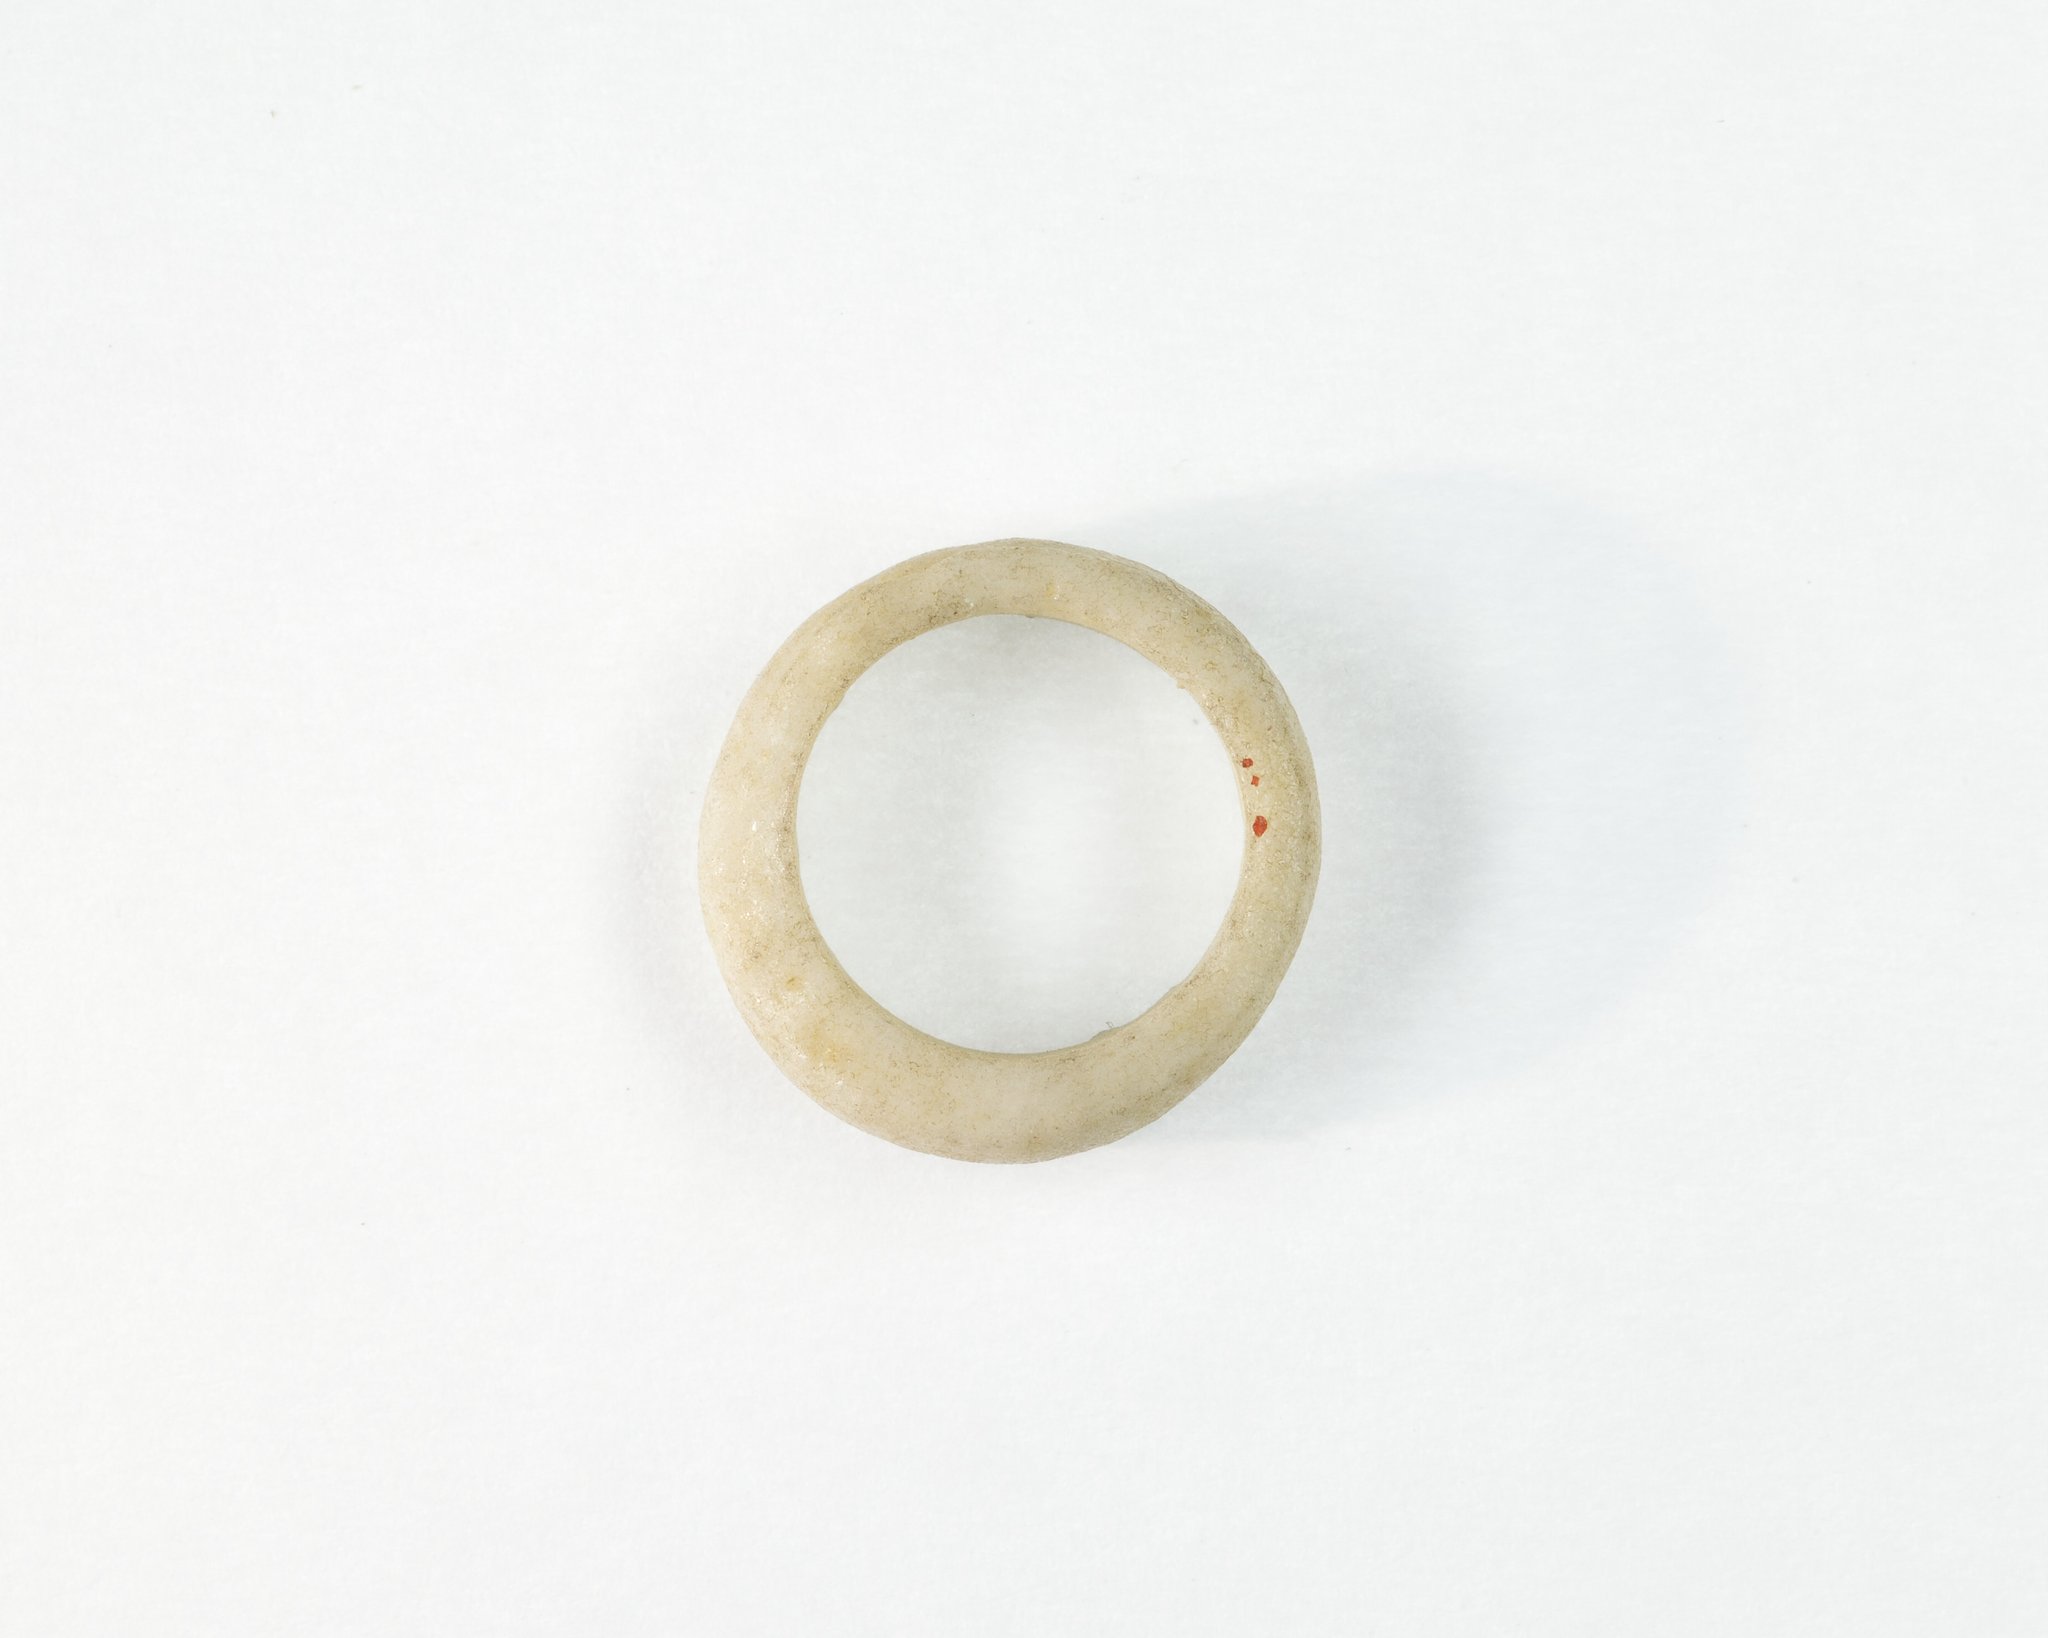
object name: ring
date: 1550-1295 BCE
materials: faience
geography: northern upper egypt